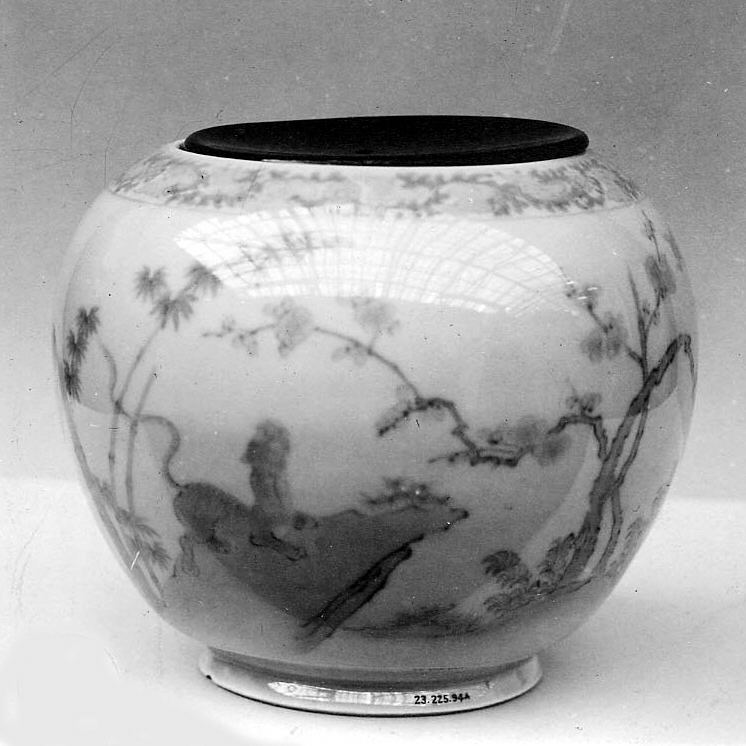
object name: jar with cover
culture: japanese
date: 1820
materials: glaze, porcelain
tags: animals,trees